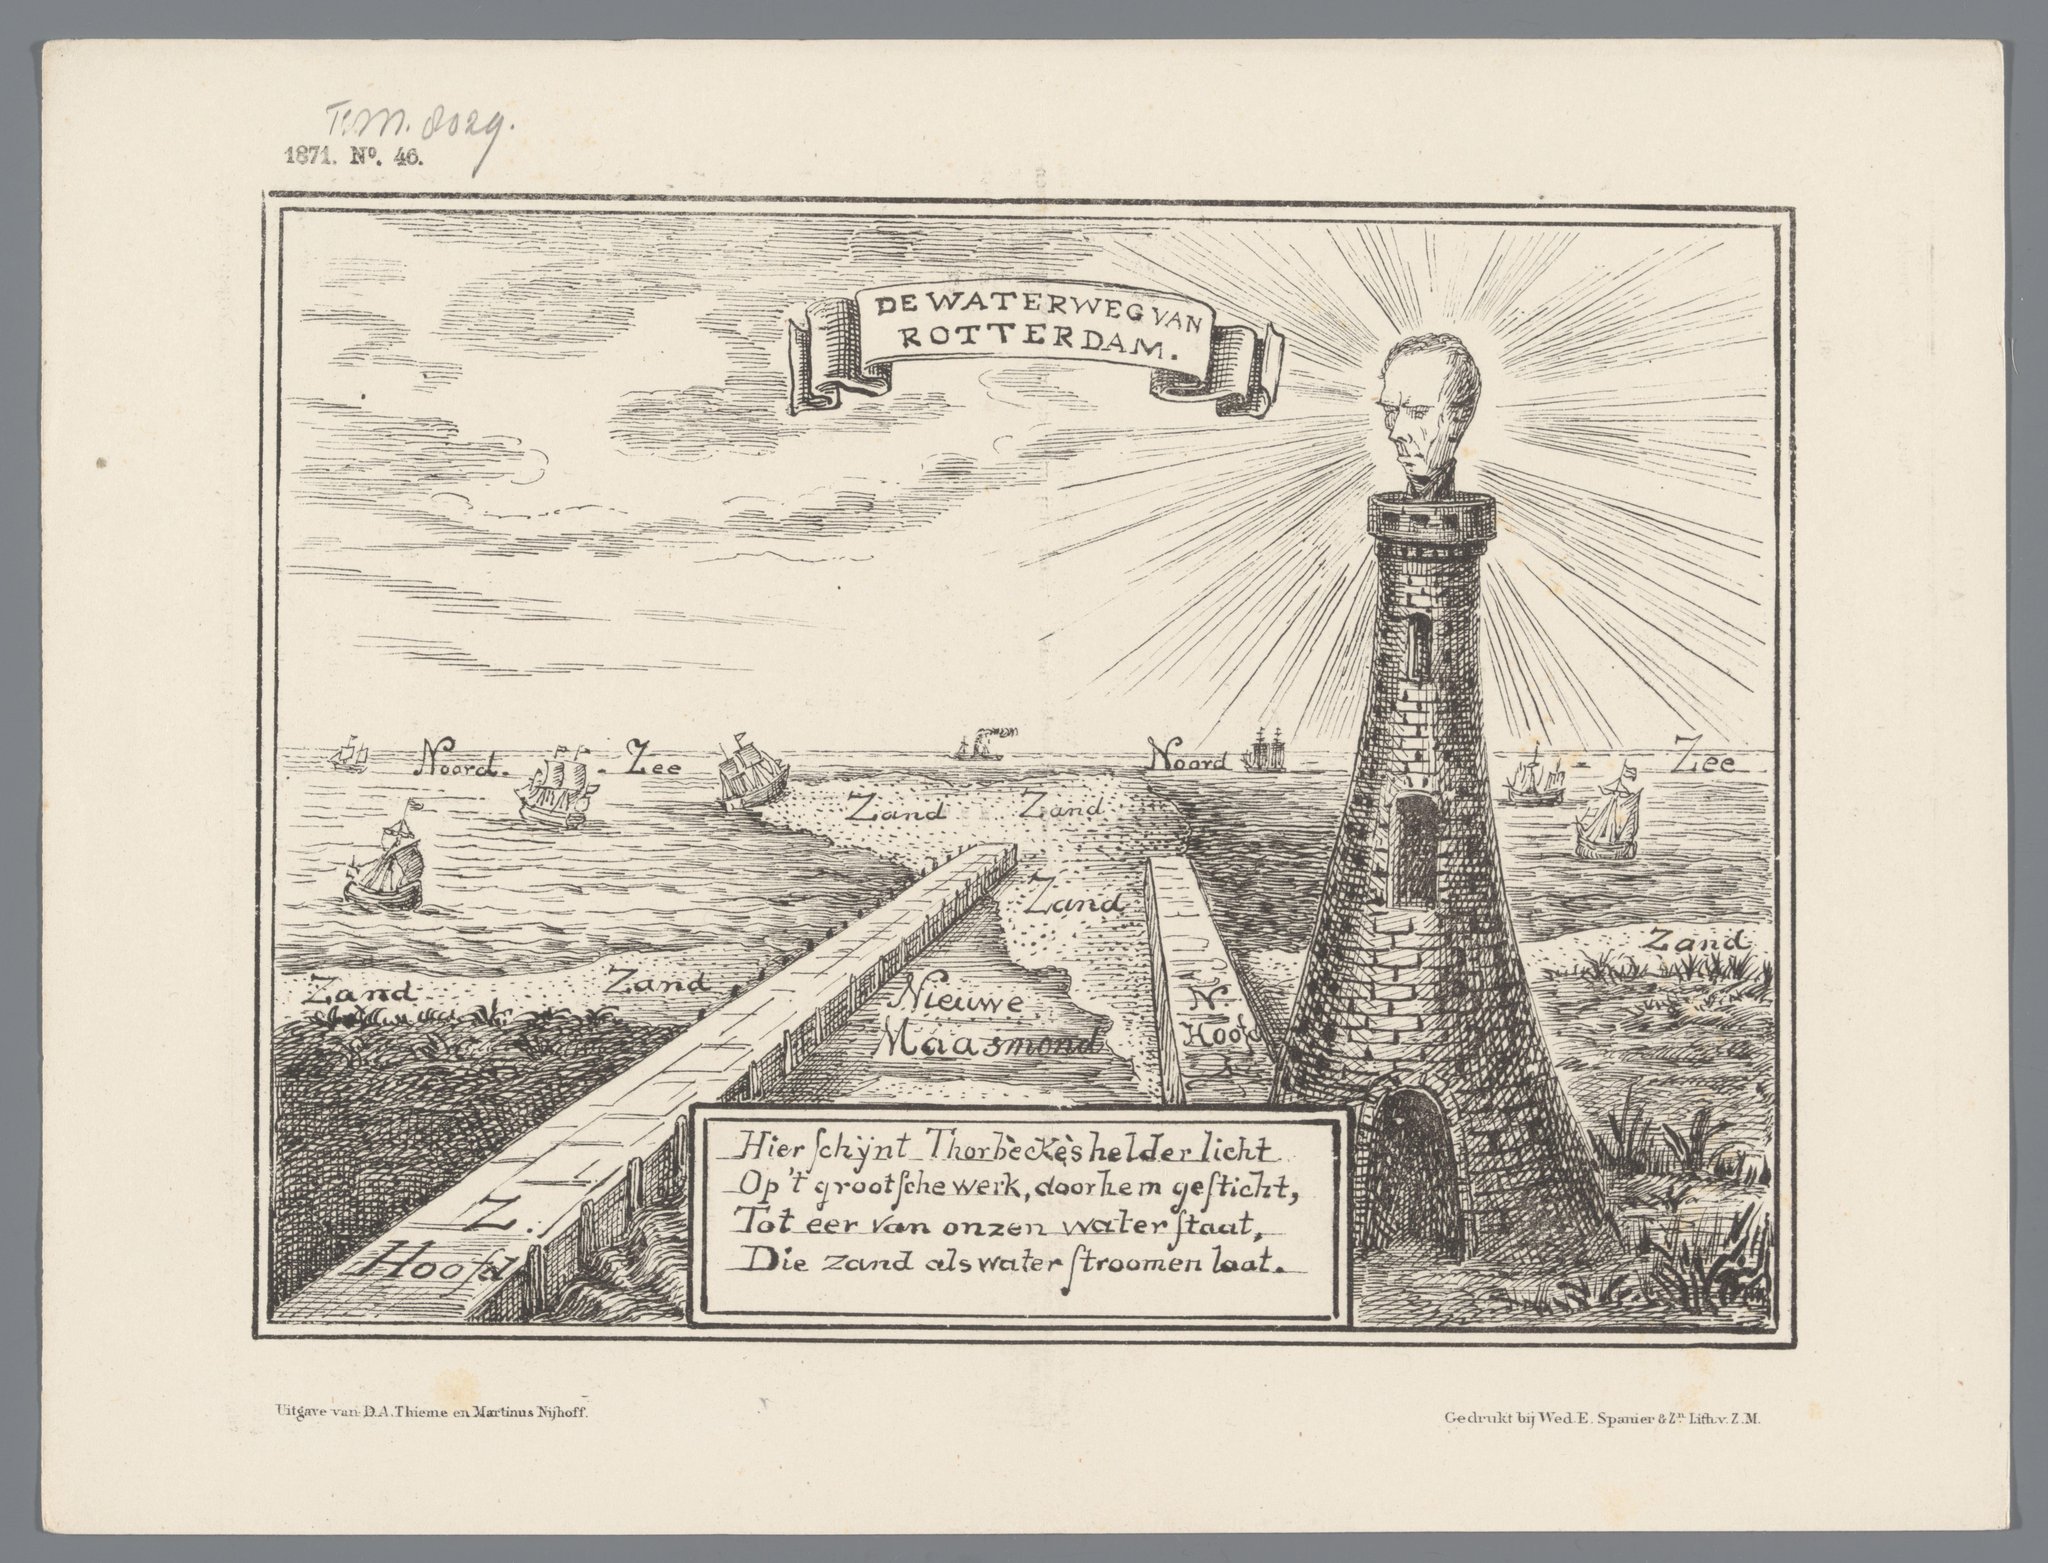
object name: cartoon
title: De waterweg van Rotterdam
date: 1871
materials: paper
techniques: lithograph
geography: netherlands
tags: the hague, johan rudolf thorbecke, lighthouse, lightship, rotterdam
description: Spotprent met Thorbecke als vuurtoren bij de verzande nieuwe waterweg van de Maas in Rotterdam. Plaat verschenen bij het weekblad De Nederlandsche Spectator, nr. 46, 1871.